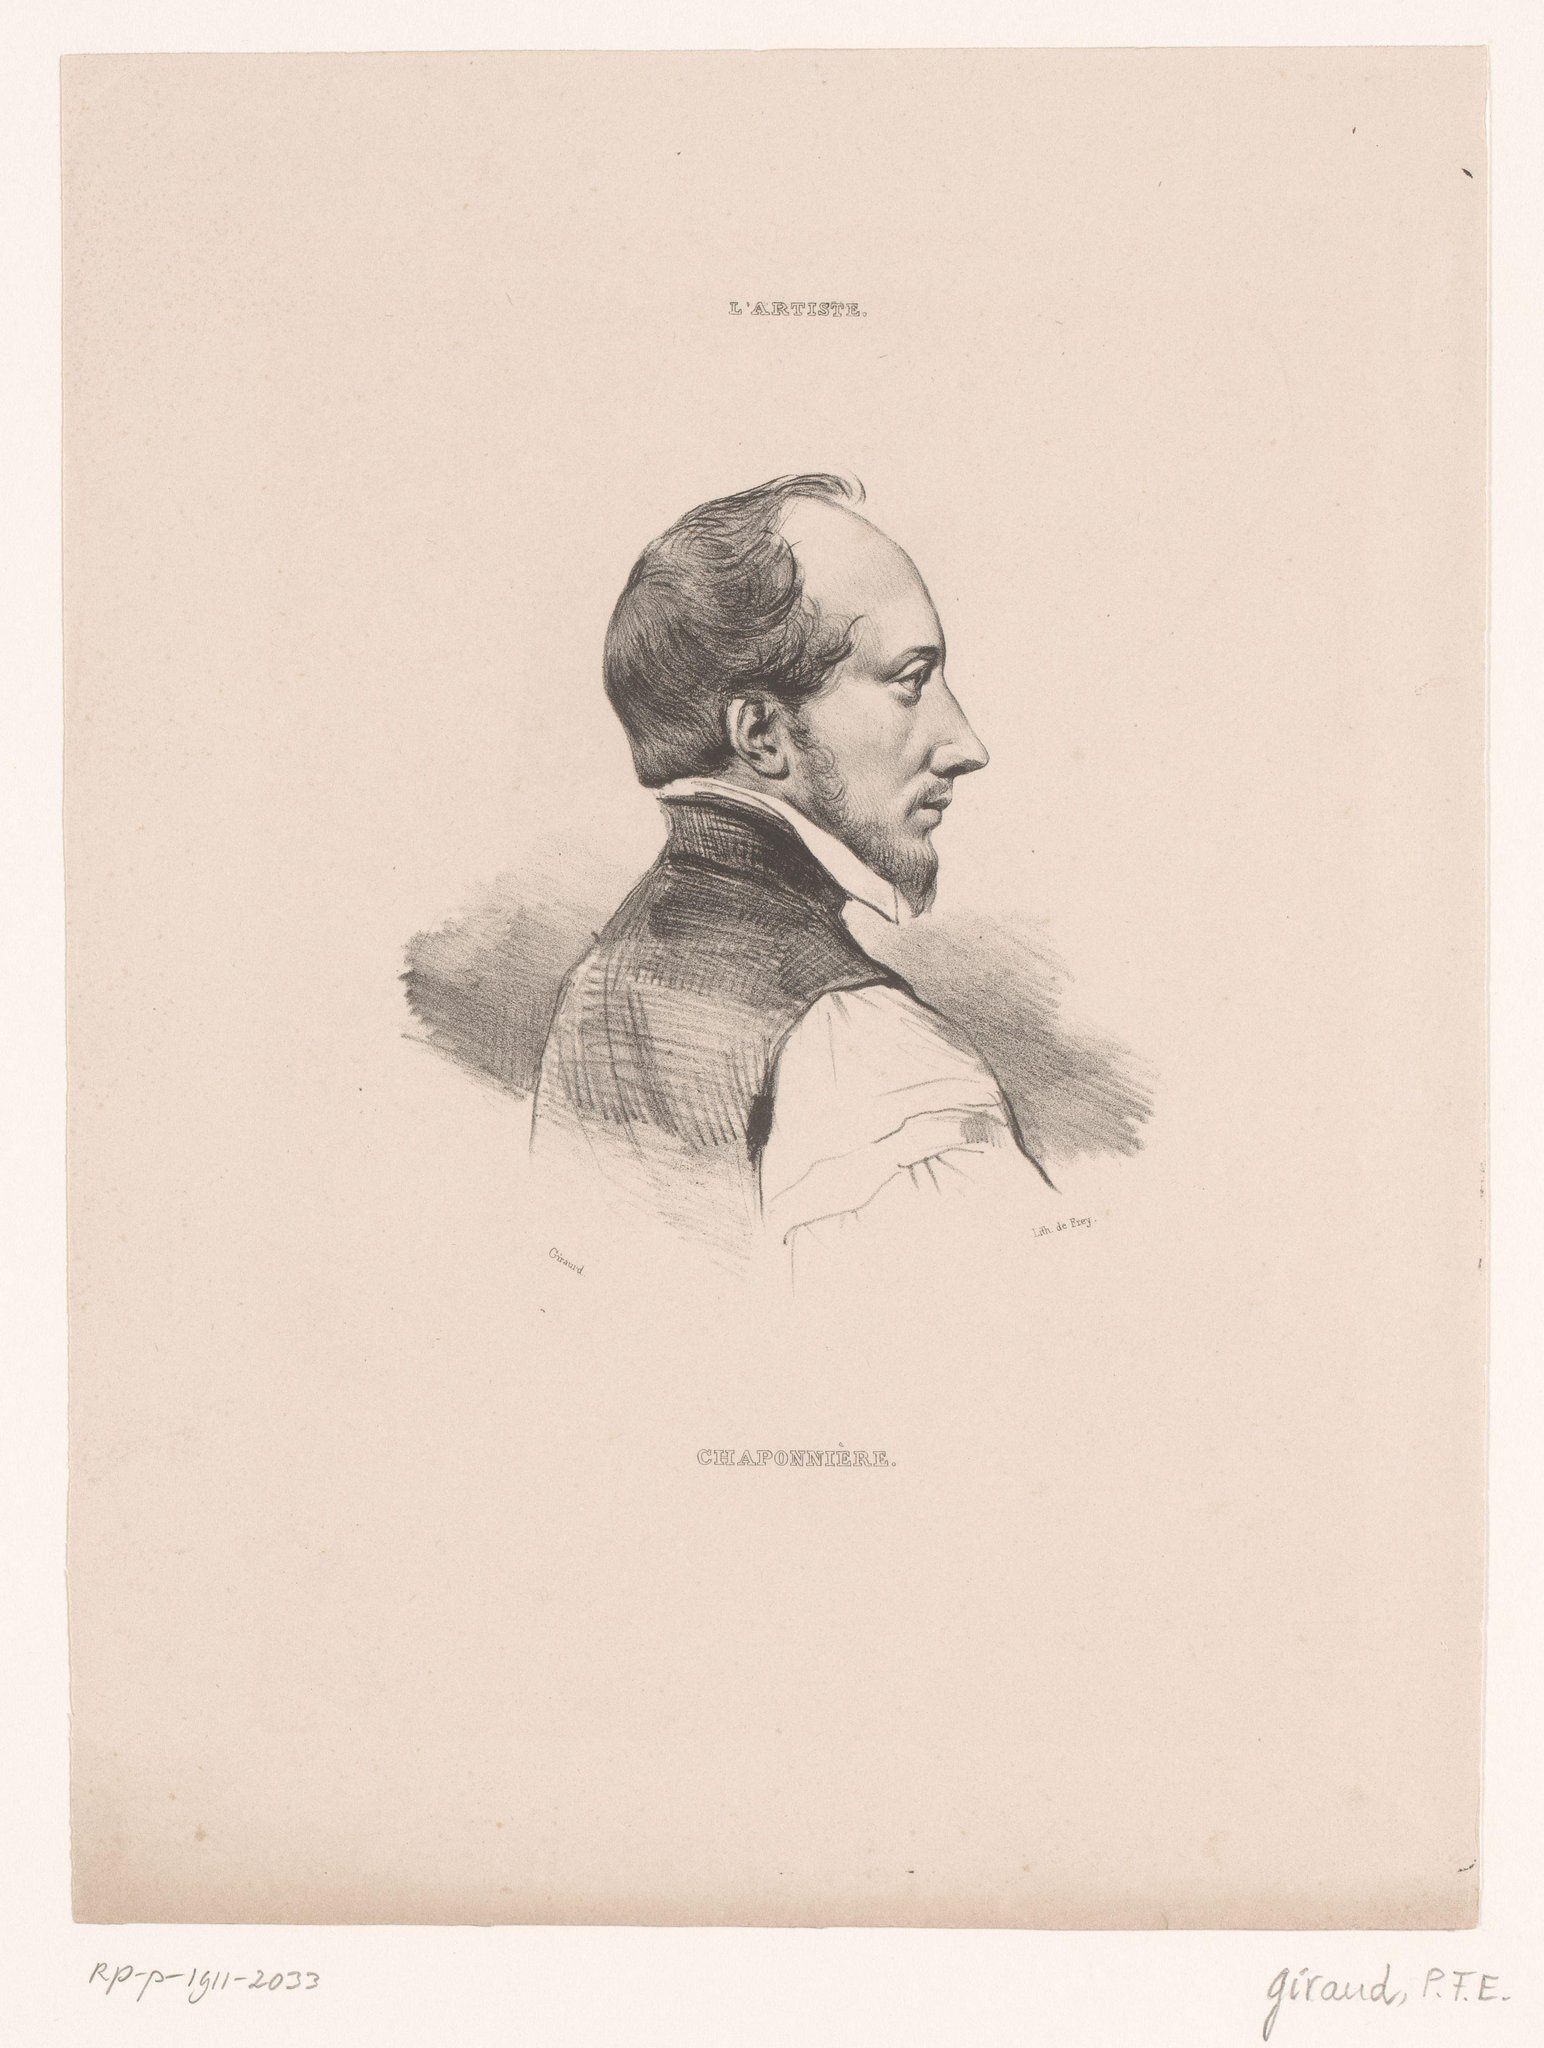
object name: print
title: Portret van Jean-Étienne Chaponnière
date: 1835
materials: paper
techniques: lithograph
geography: paris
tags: jean-etienne chaponnière, historical persons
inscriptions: collector's mark: Lugt 2228a